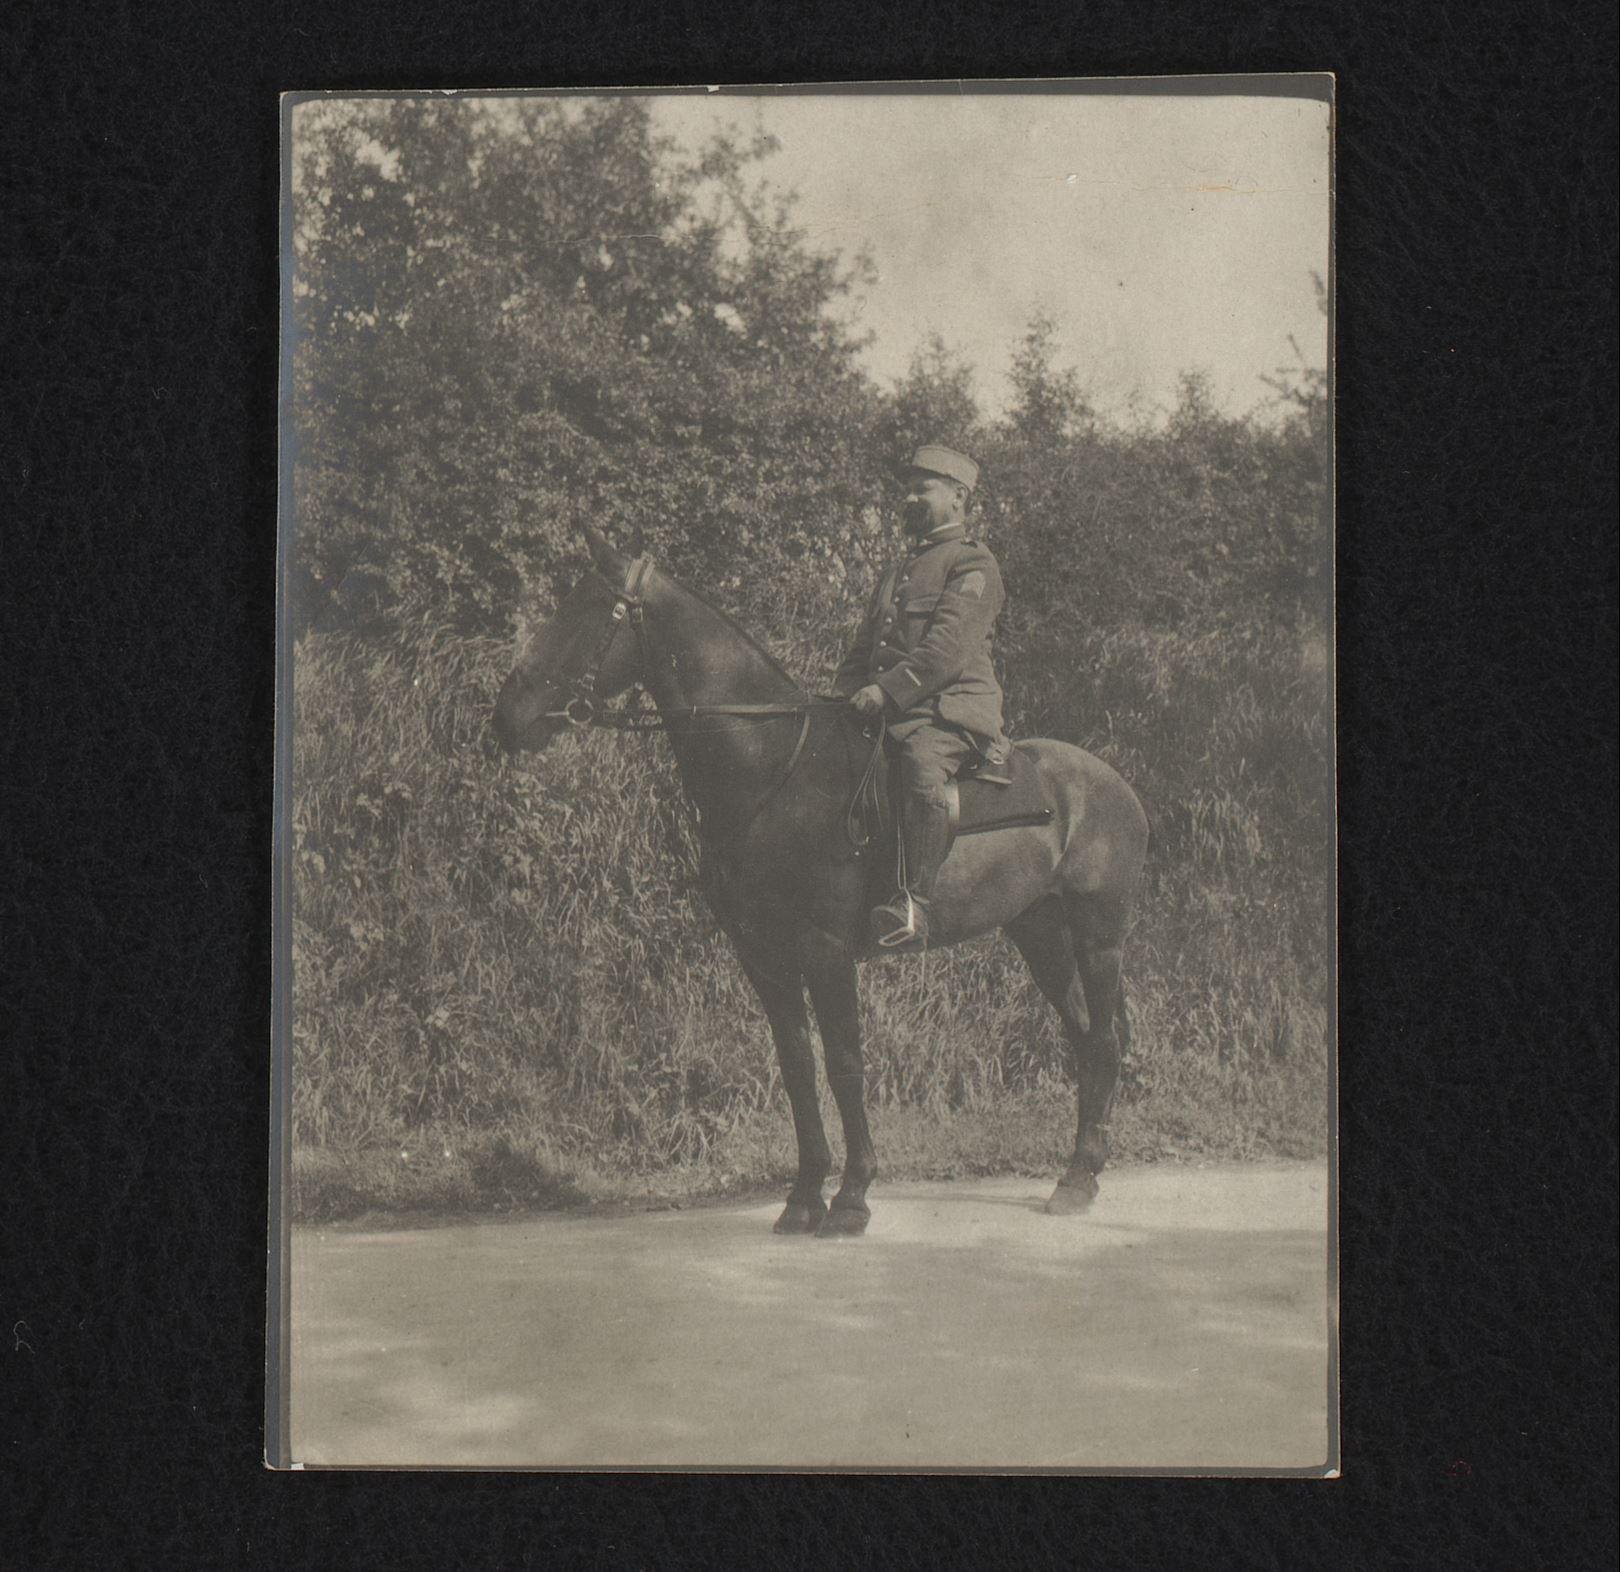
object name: photograph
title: Ruiter te paard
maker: Anonymous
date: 1900-1940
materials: photographic support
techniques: gelatin silver print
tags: riding a horse, ass, or mule; rider, horseman